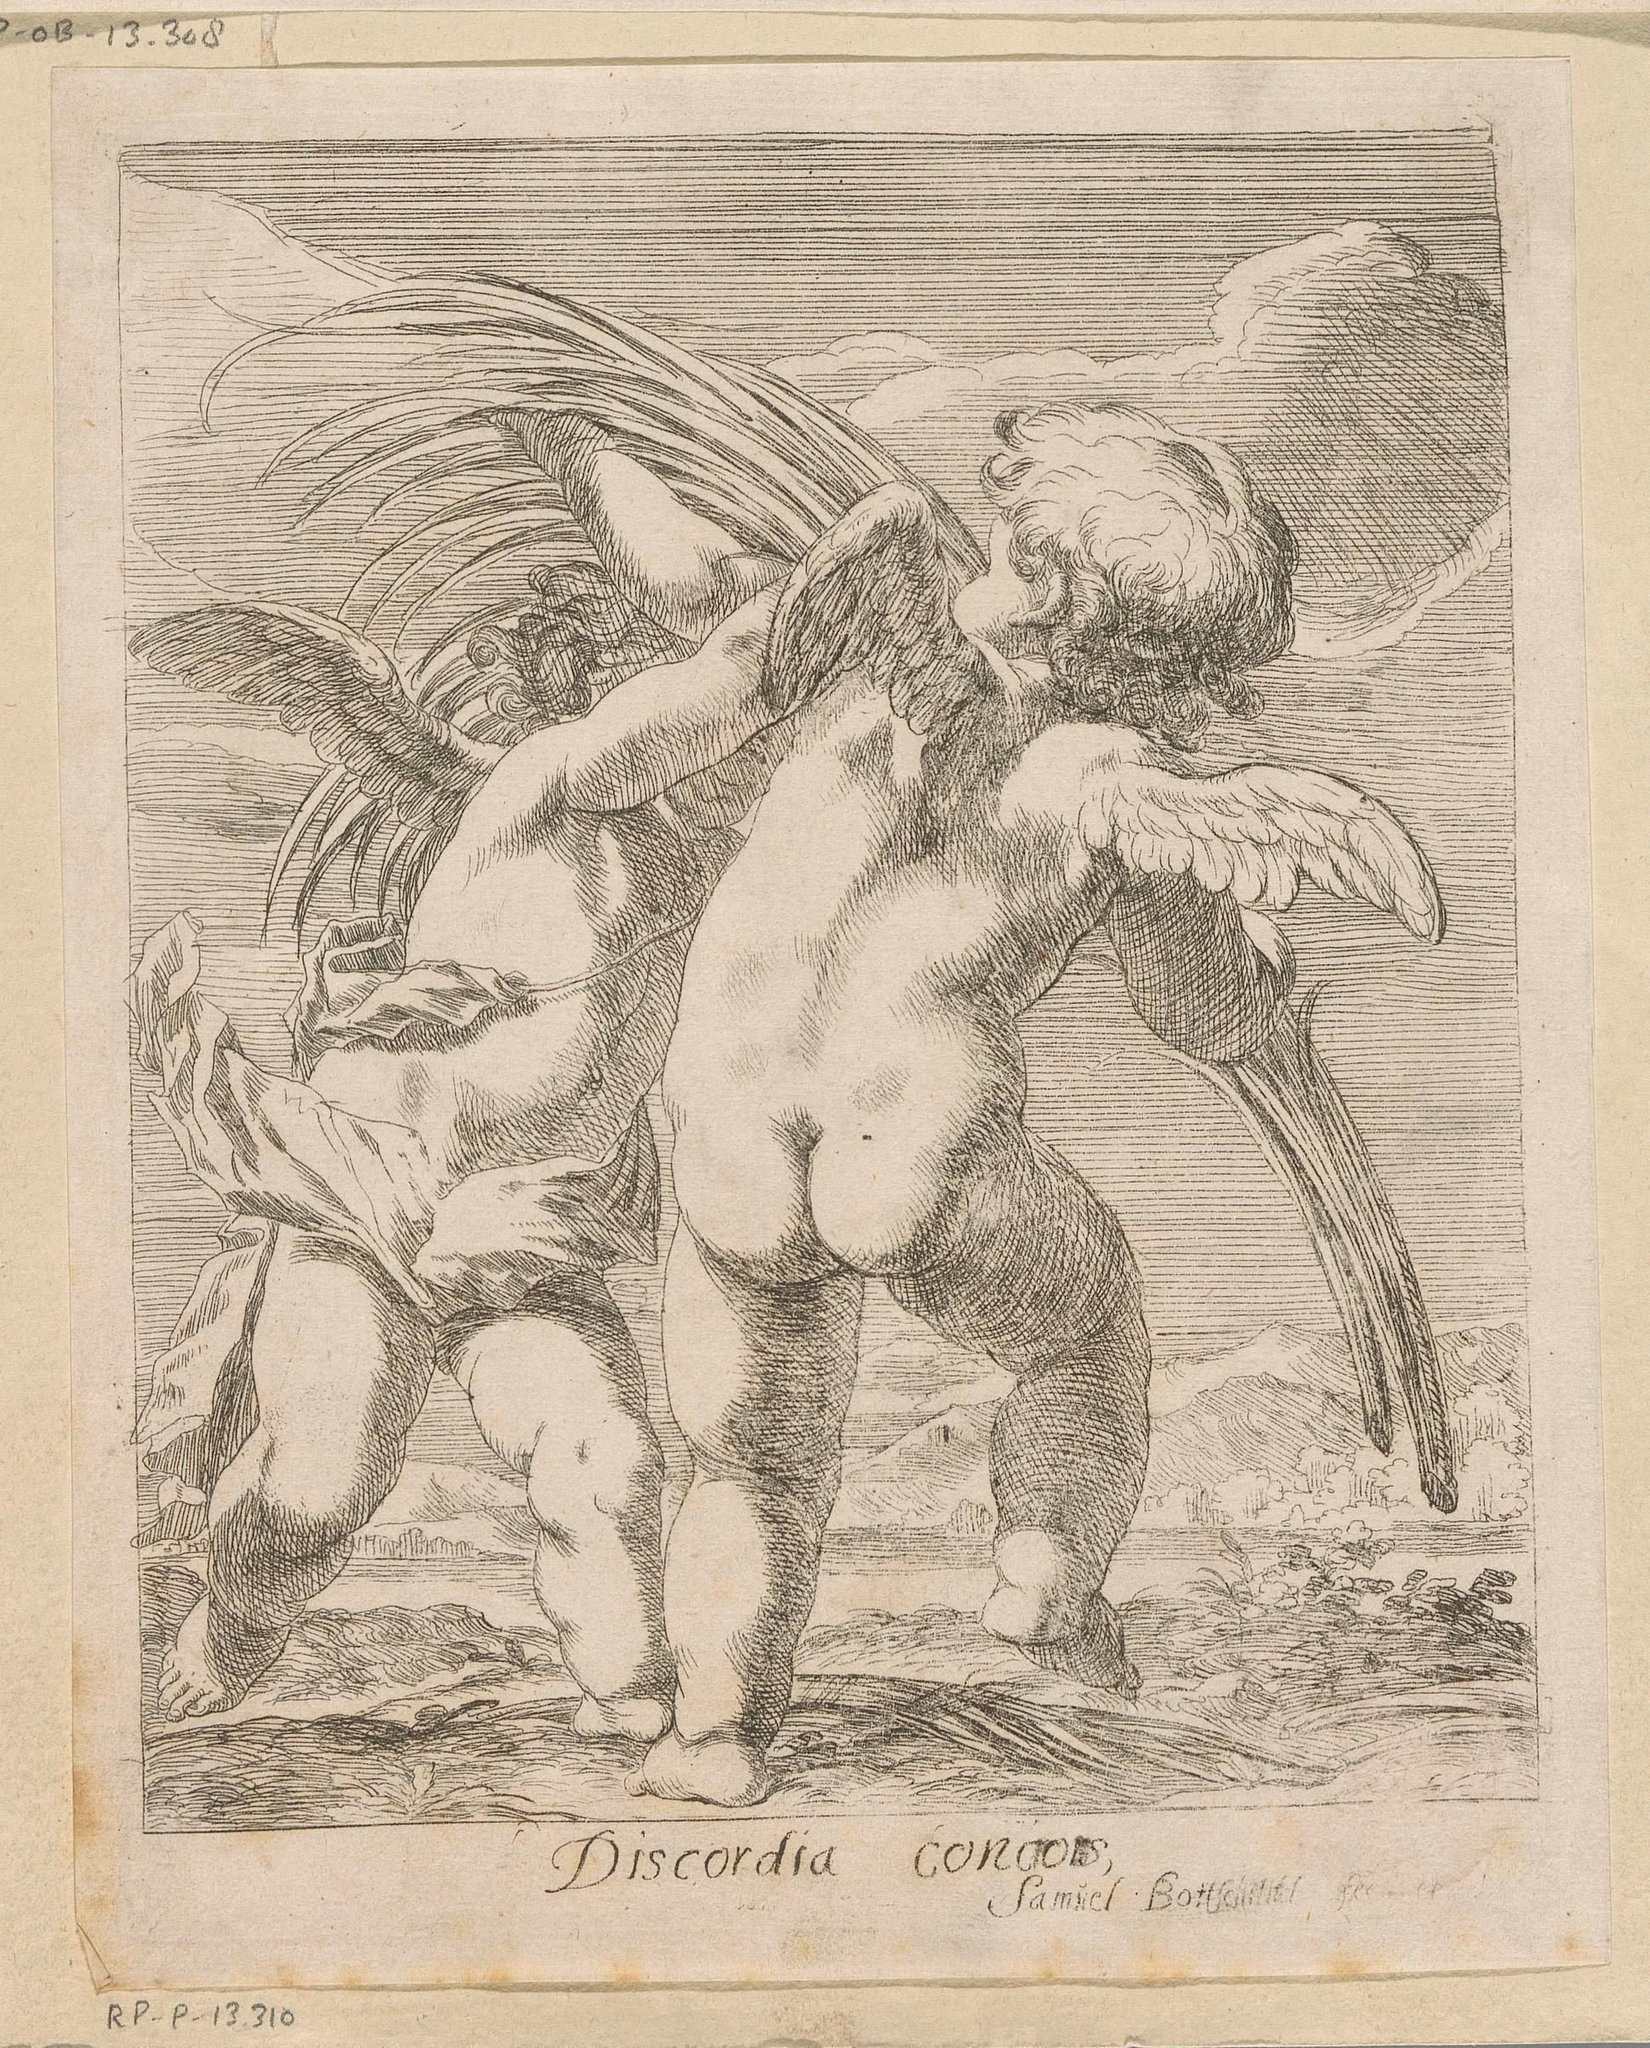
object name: print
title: Twee putti ruziën om een palmtak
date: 1693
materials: paper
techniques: etching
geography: dresden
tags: quarrel, argument, trees: palm-tree, cupids: 'amores', 'amoretti', 'putti'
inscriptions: collector's mark: Lugt 240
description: Prent afkomstig uit de serie 'Opera Varia Historica, Poetica & Iconologica', uitgegeven in 1693. Deze serie omvat vrijwel het complete oeuvre van de kunstenaar en bestaat uit 48 prenten, voornamelijk ontwerpen voor plafonds.